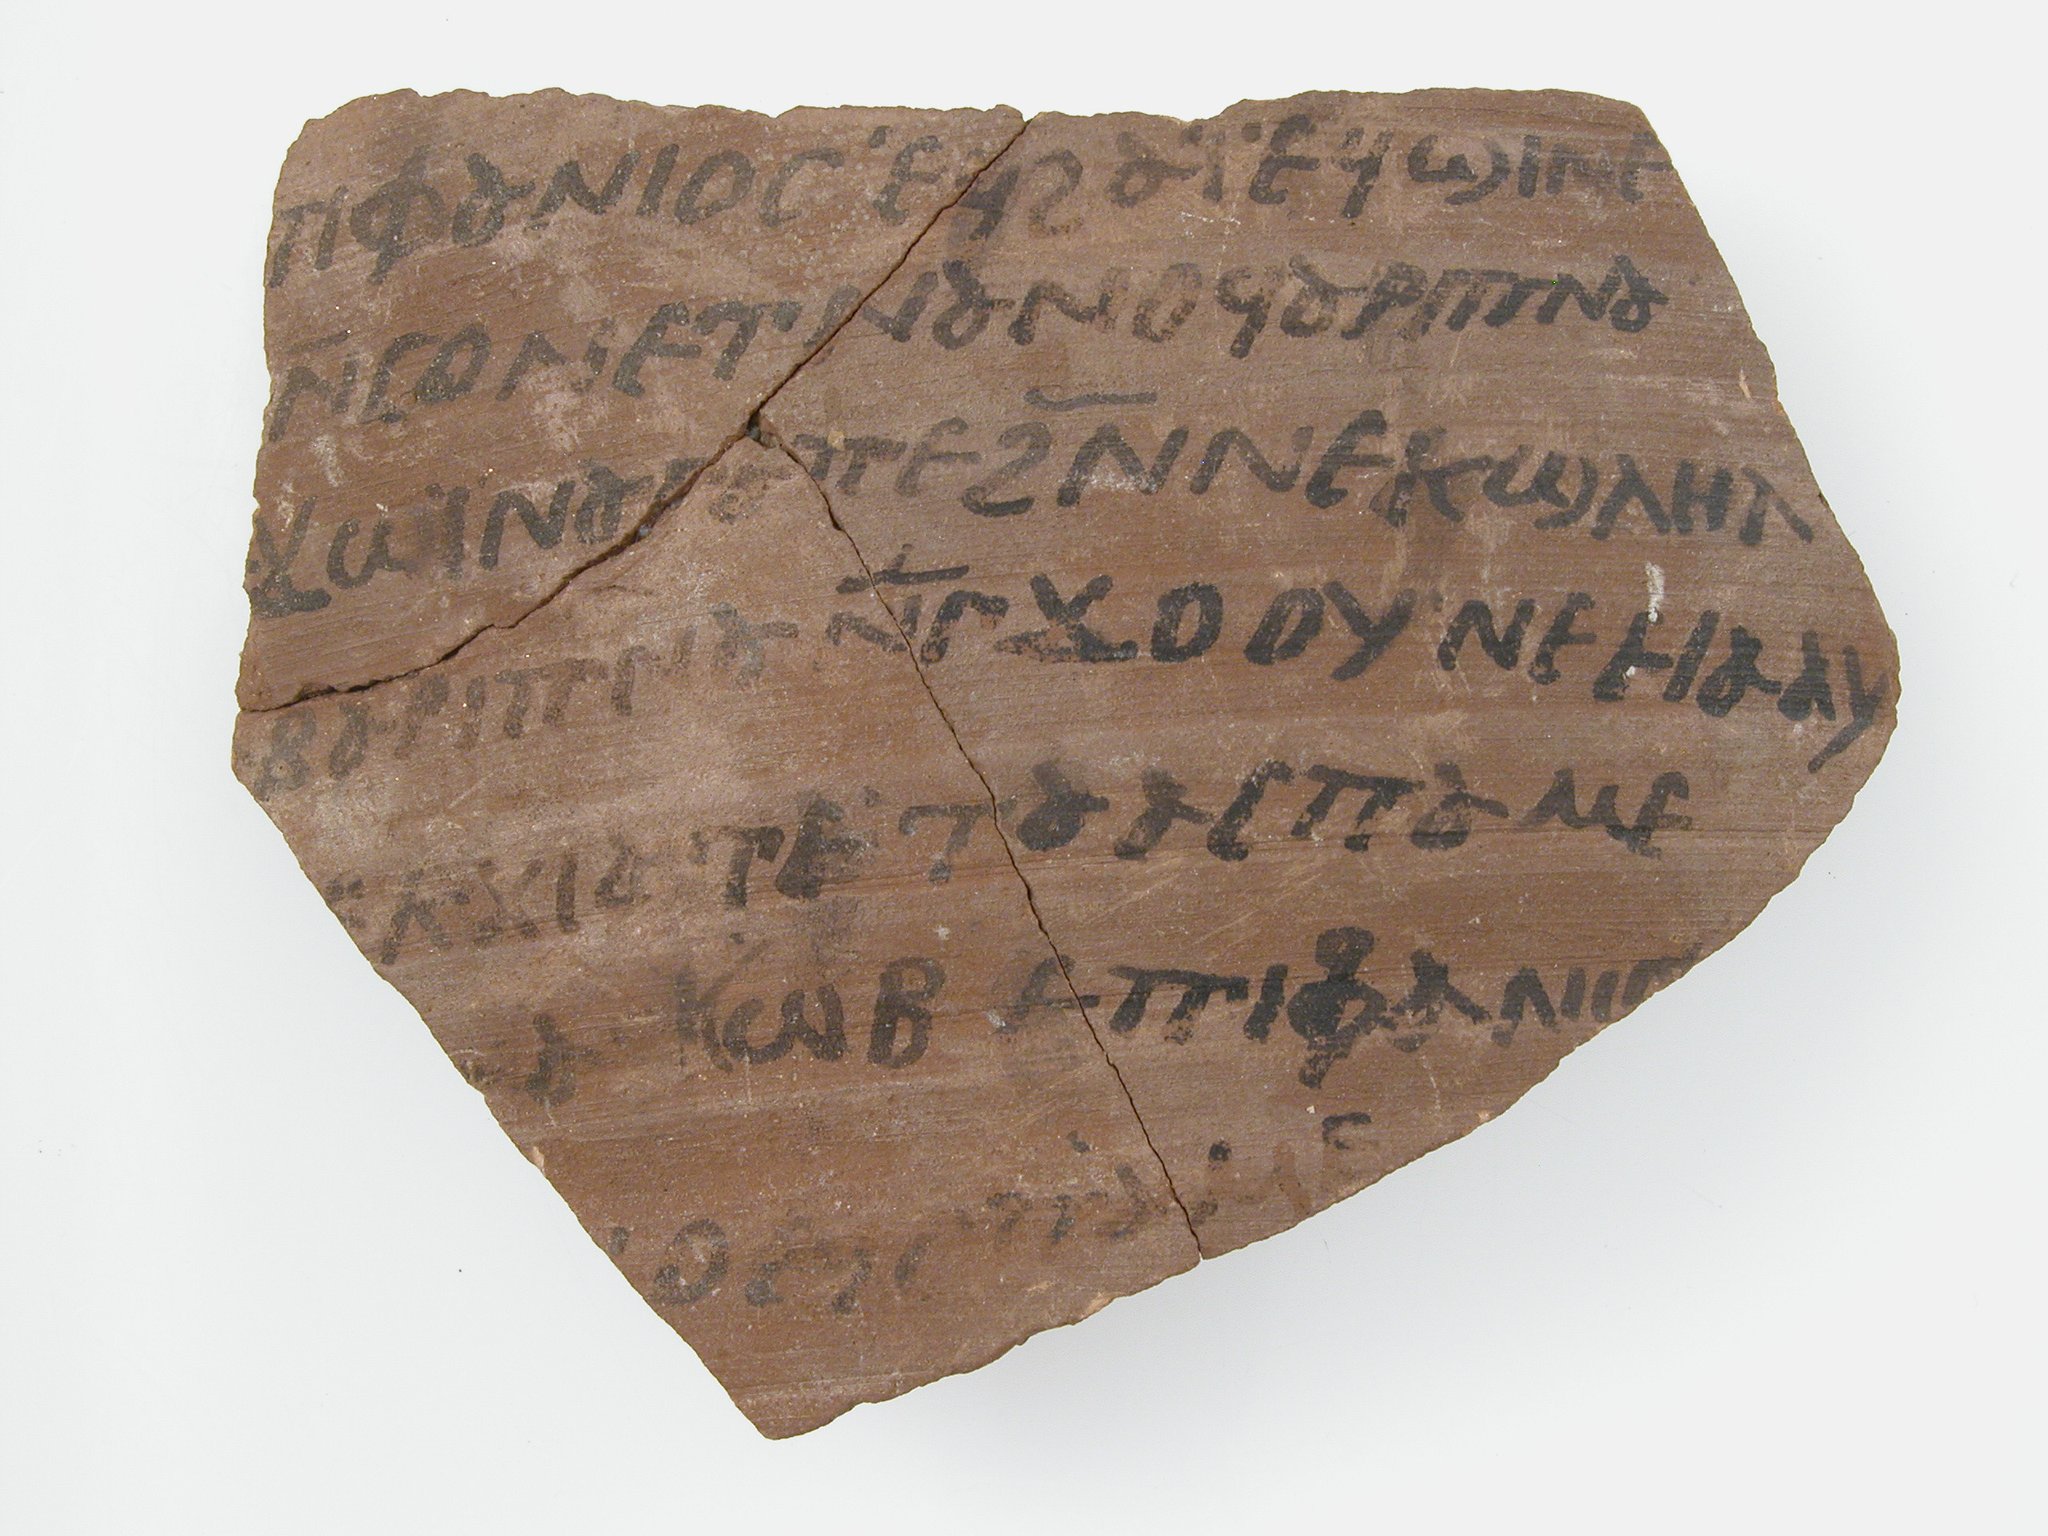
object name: ostrakon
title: Ostrakon with a Letter from Epiphanius to Jacob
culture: coptic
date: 600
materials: ink, pottery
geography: egypt